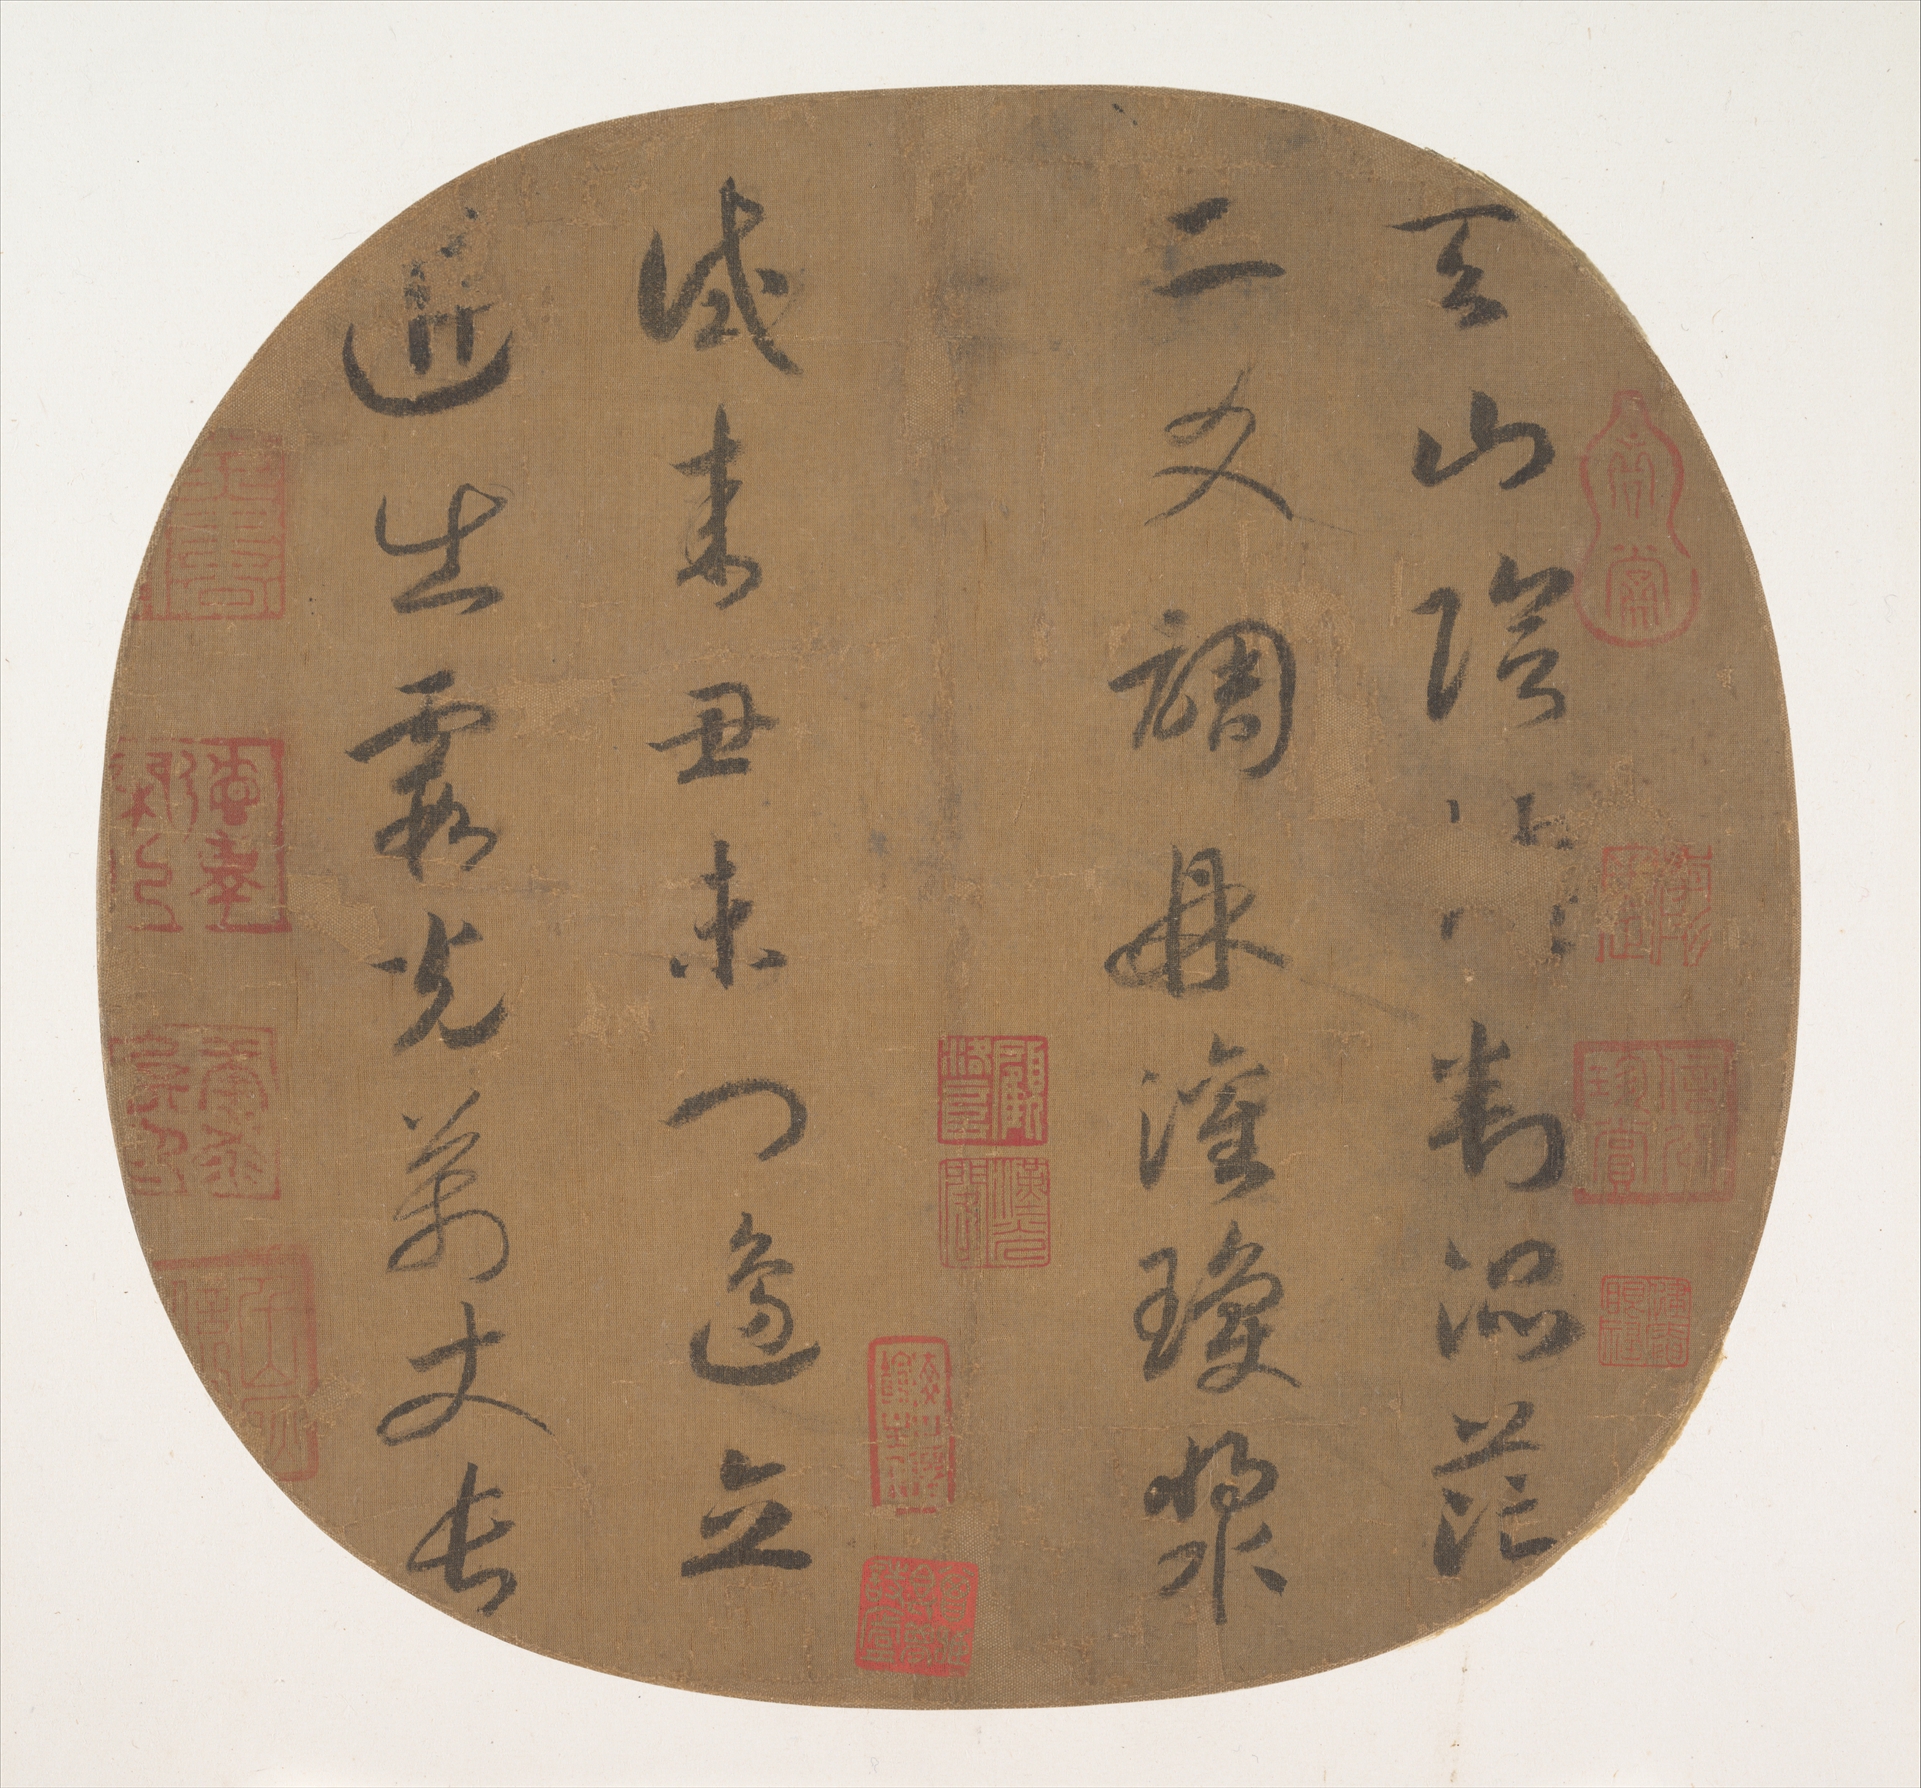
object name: fan mounted a an album leaf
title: Quatrain on Heavenly Mountain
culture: chinese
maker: emperor gaozong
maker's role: artist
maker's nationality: chinese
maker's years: 1107-1187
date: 1162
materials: ink, silk